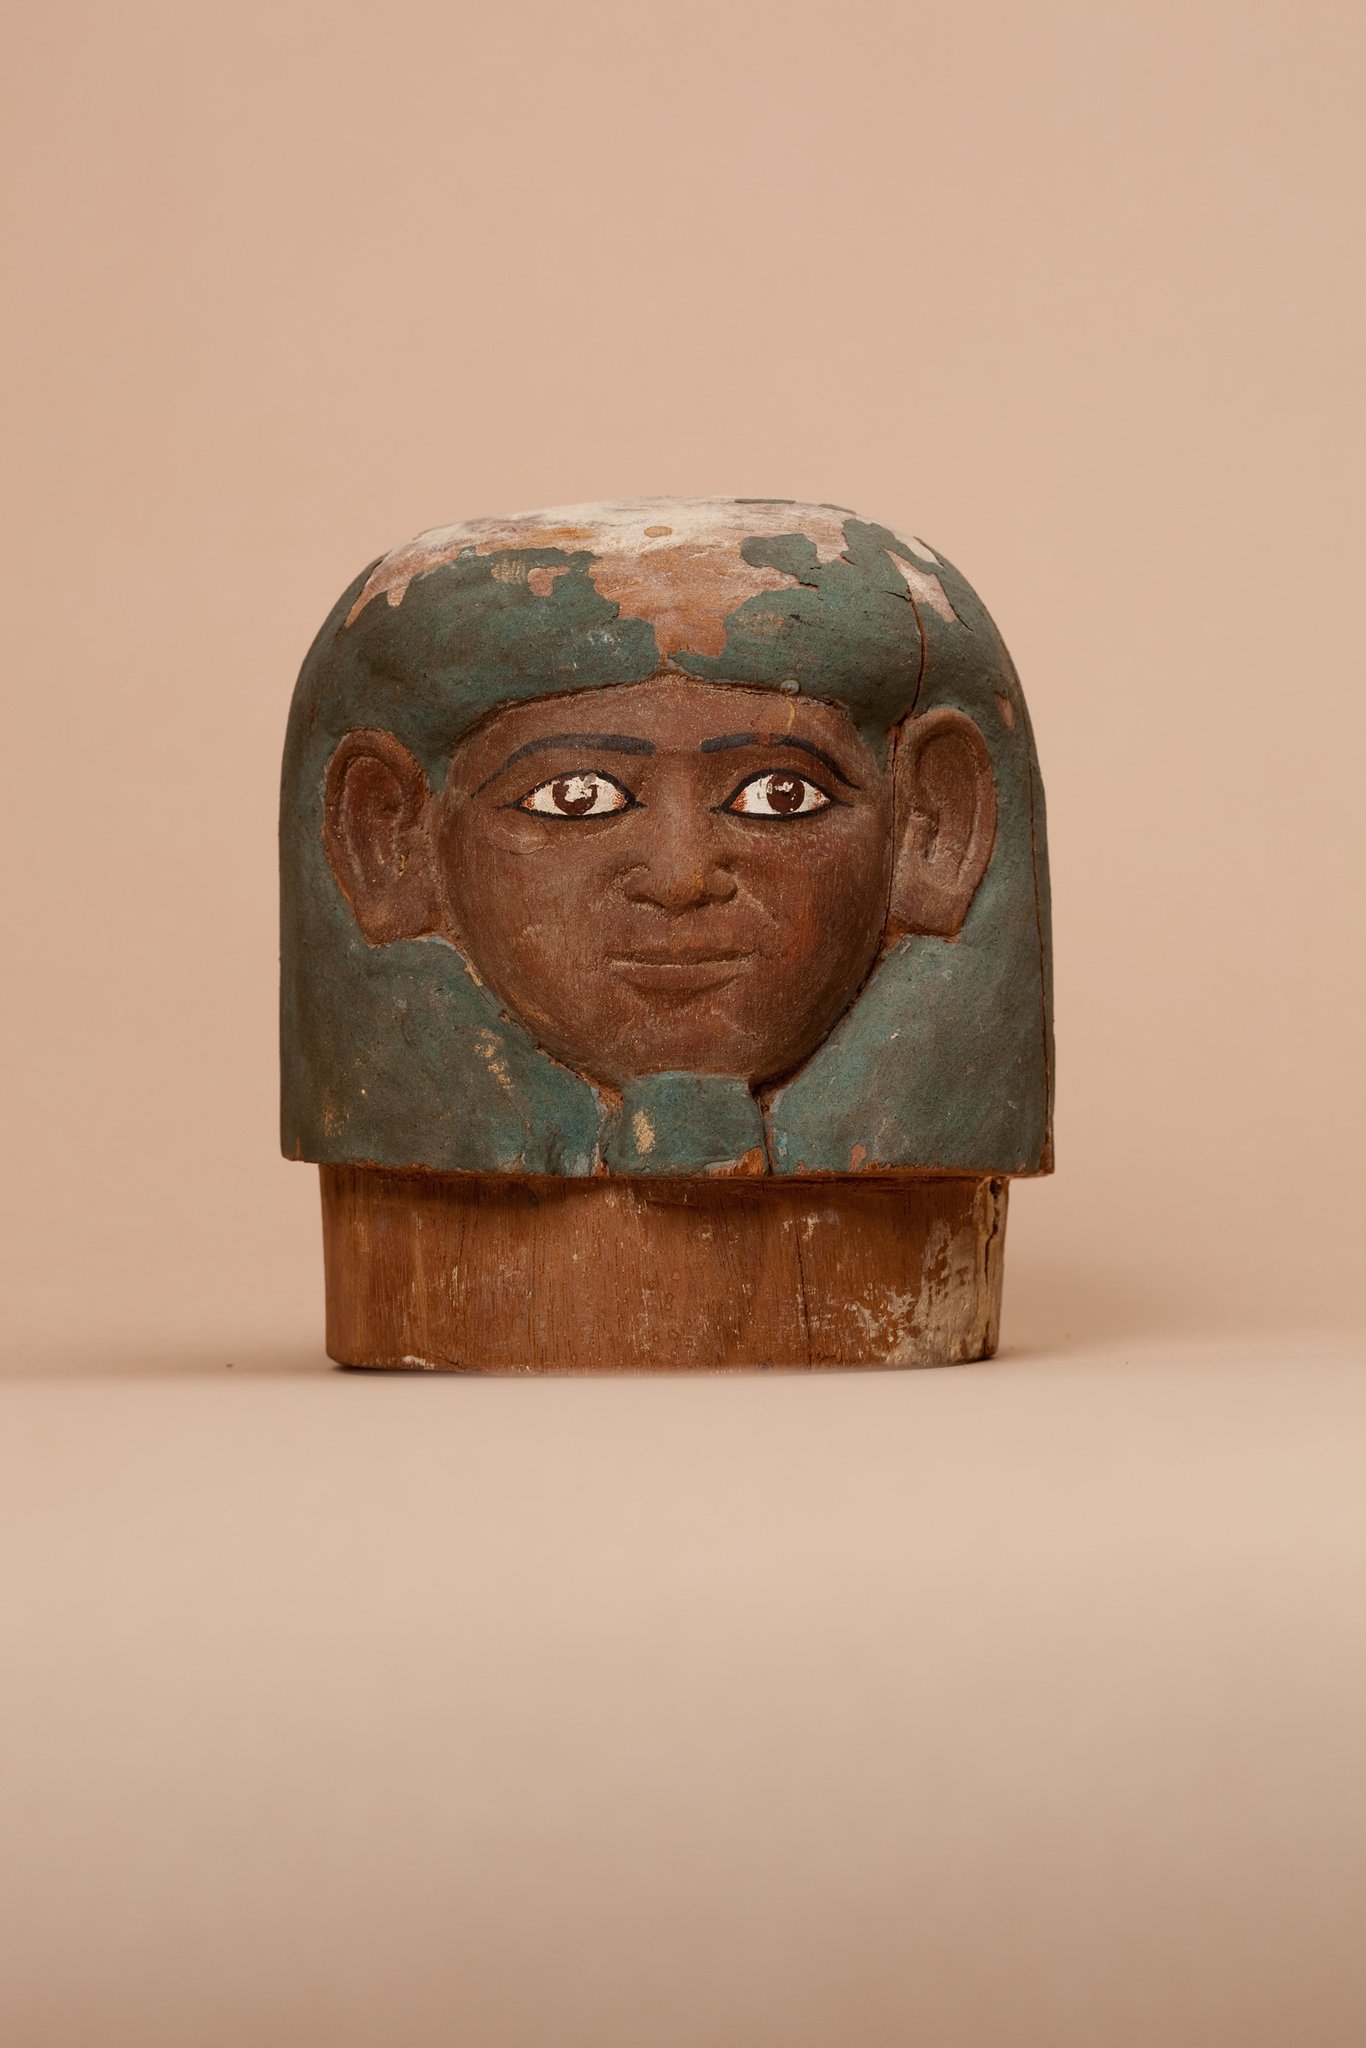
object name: canopic jar lid, ukhhotep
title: Canopic jar lid of Ukhhotep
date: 1981-1802 BCE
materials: paint, wood